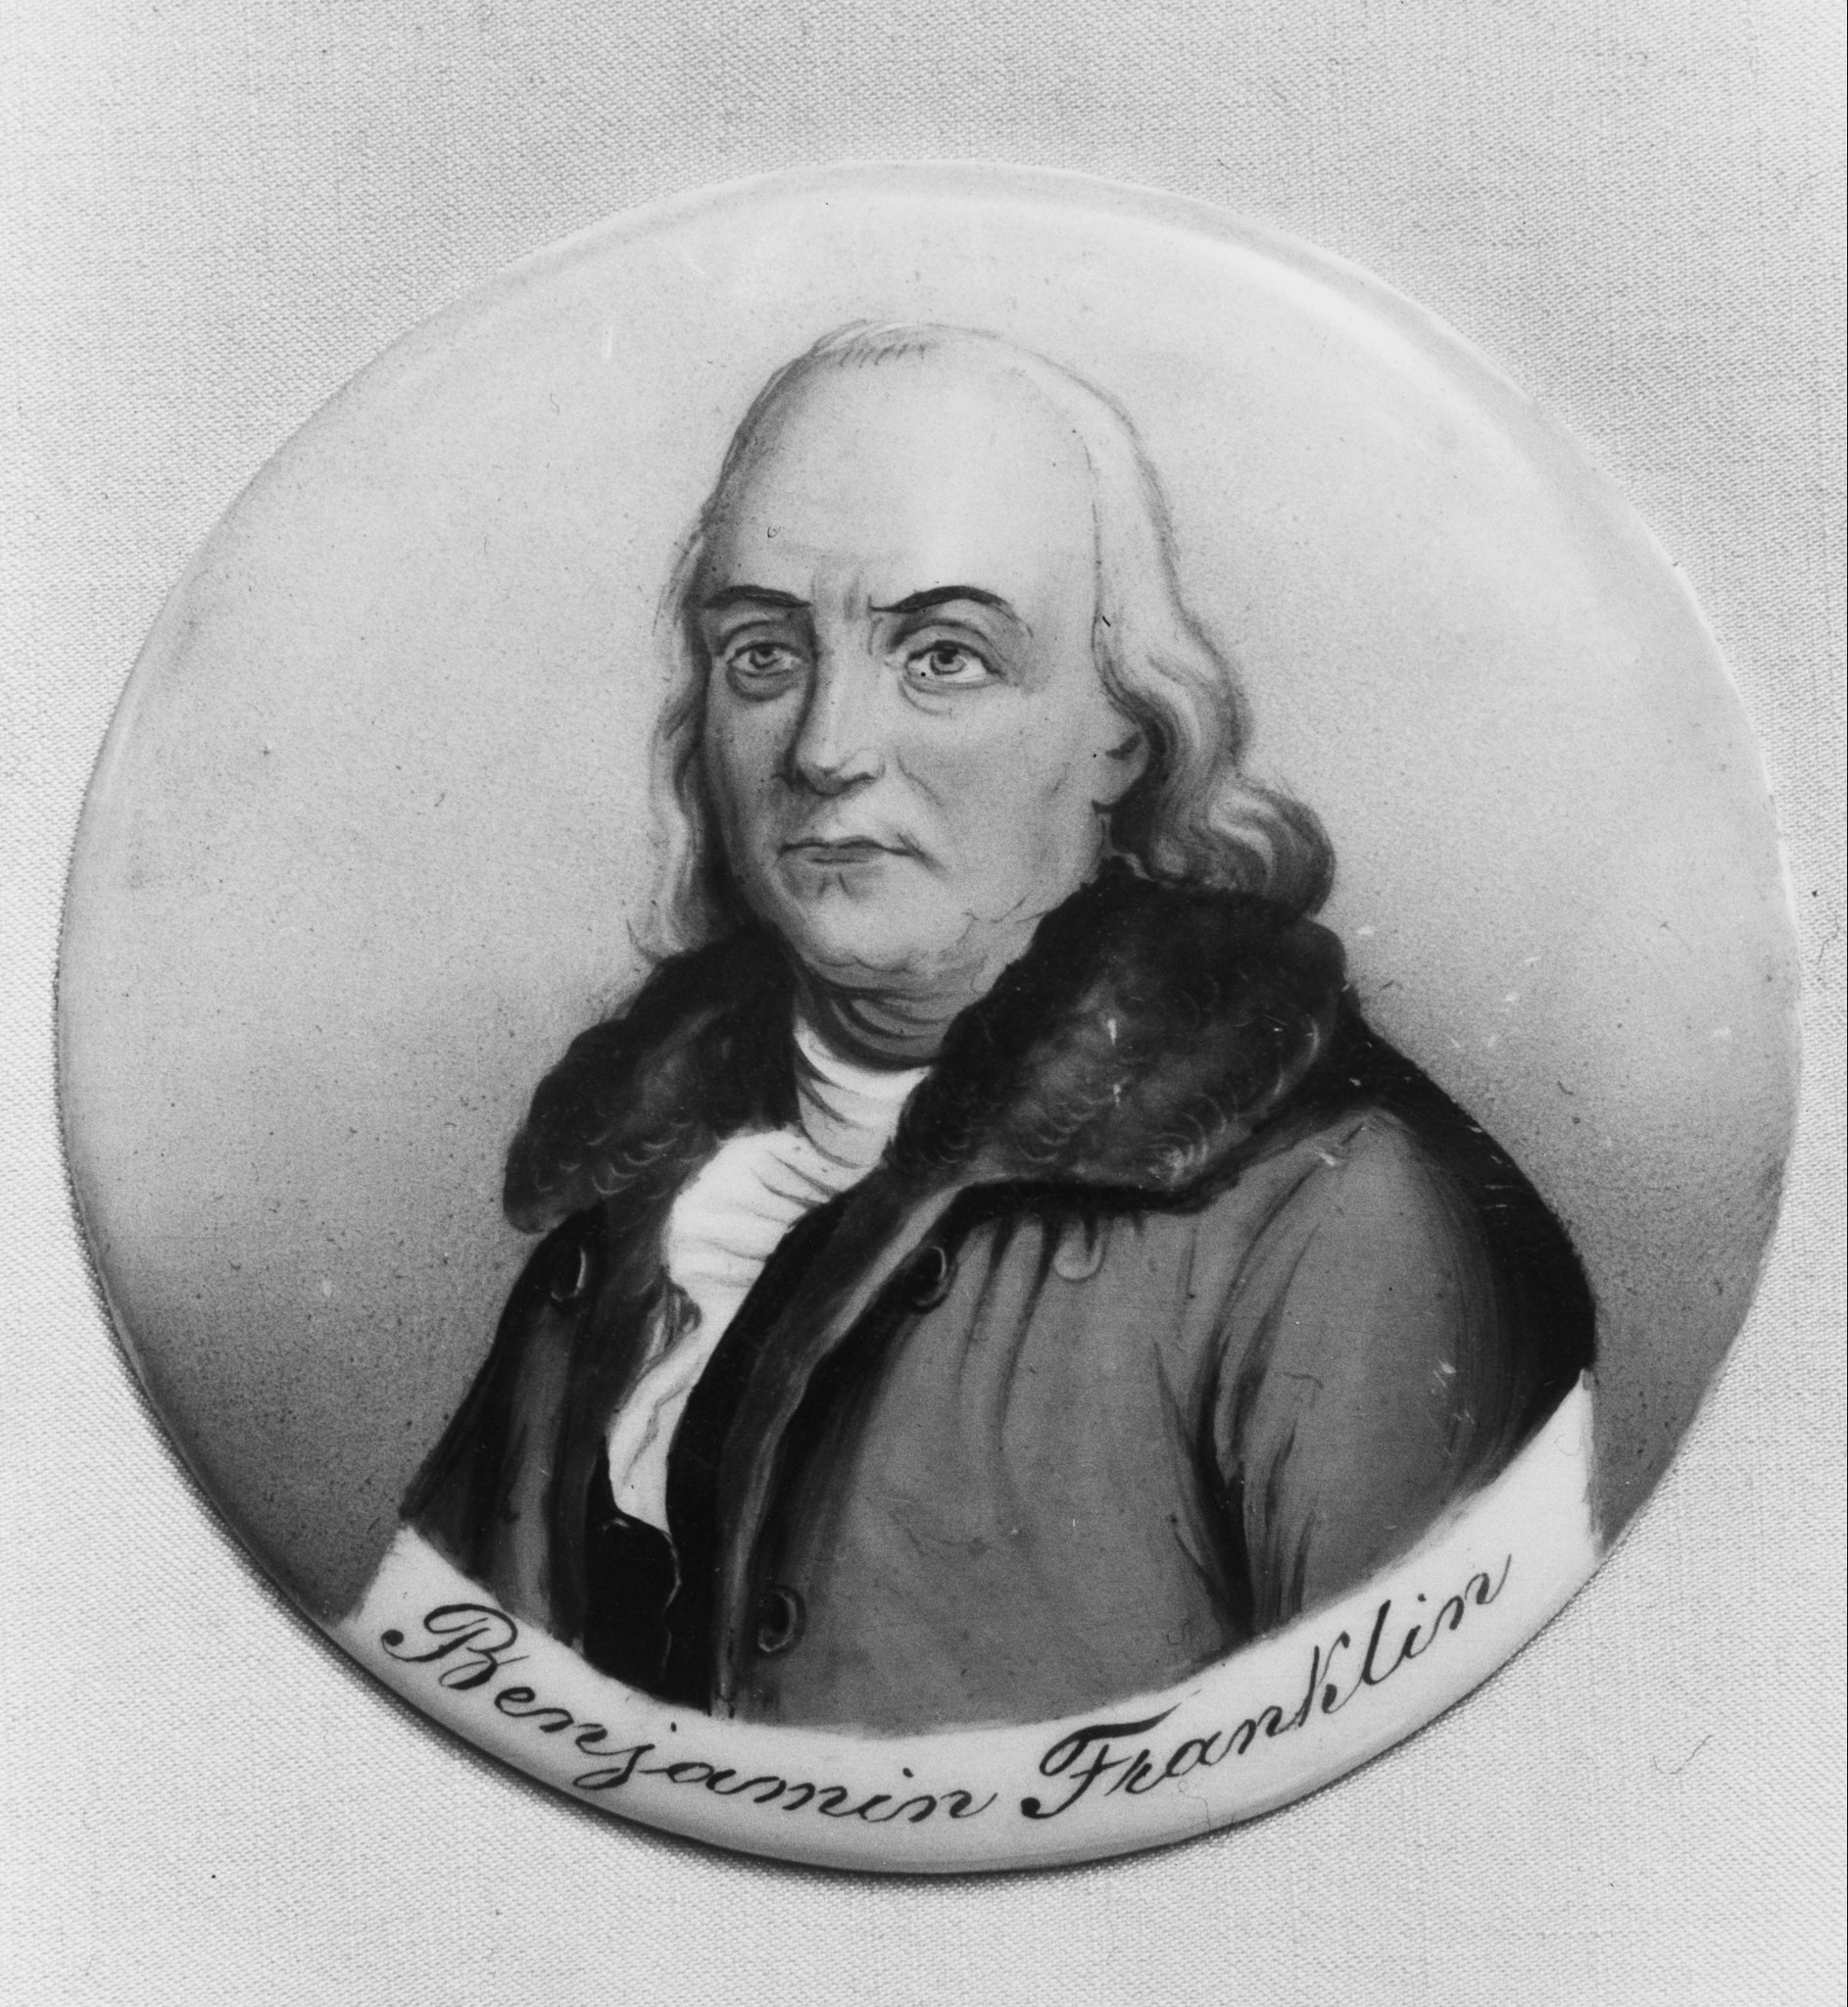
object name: plaque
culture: french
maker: joseph siffred duplessis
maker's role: maker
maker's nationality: french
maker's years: 1725-1802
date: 1770-1800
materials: porcelain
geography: france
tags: benjamin franklin,portraits